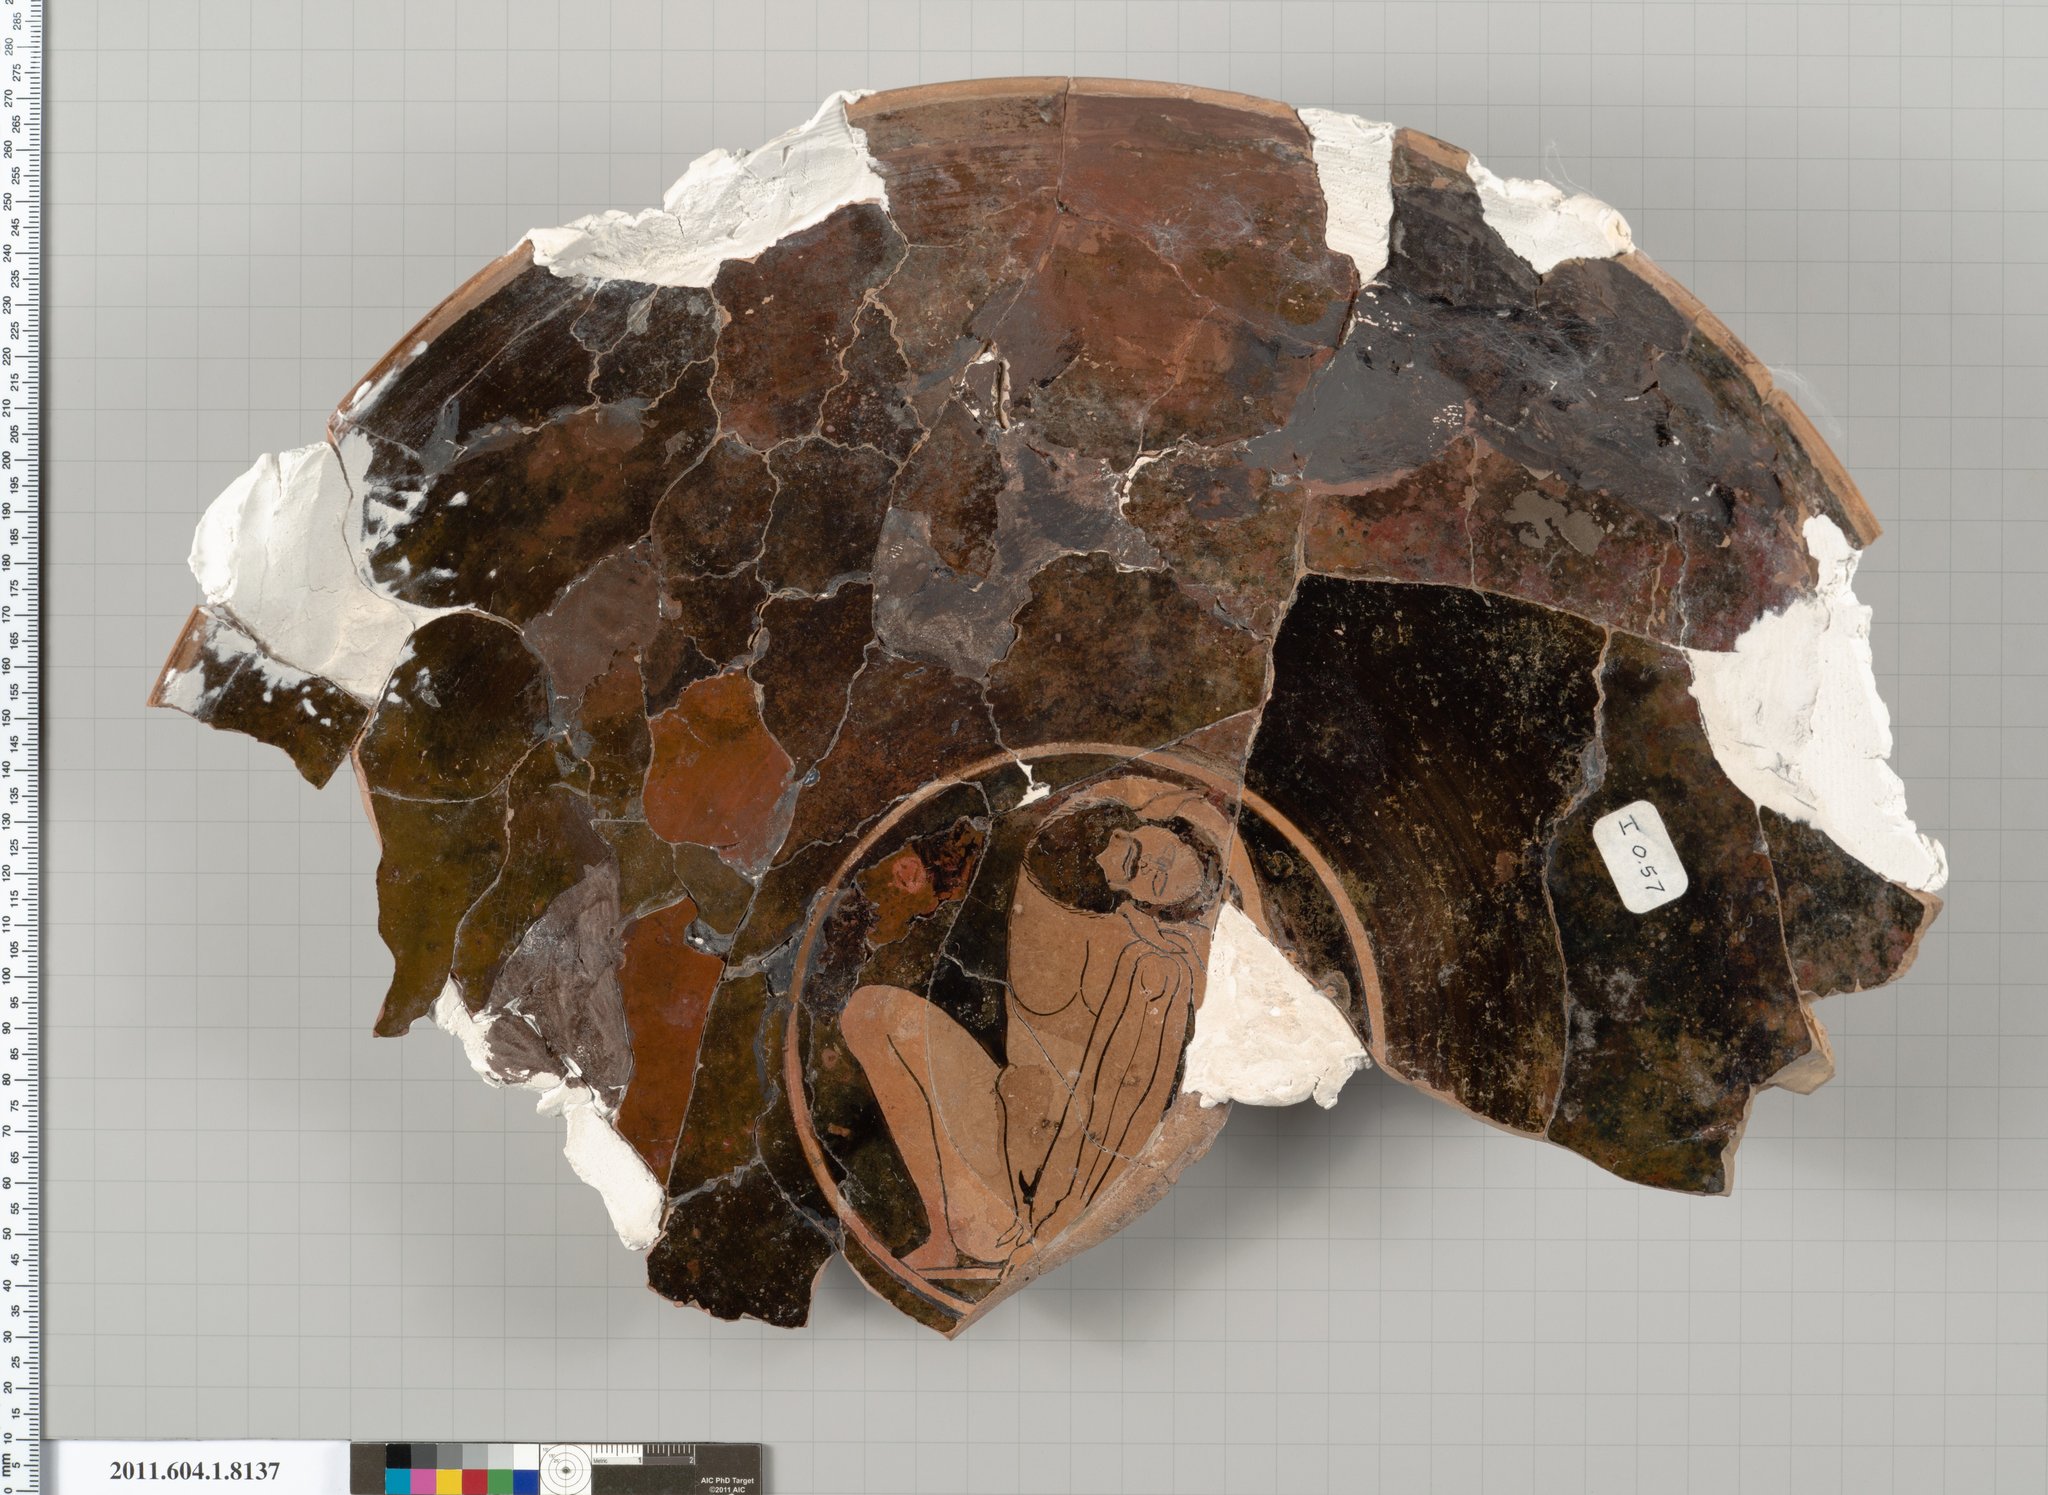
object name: kylix fragment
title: Terracotta fragment of a kylix (drinking cup)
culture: greek, attic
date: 525-501 BCE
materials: terracotta